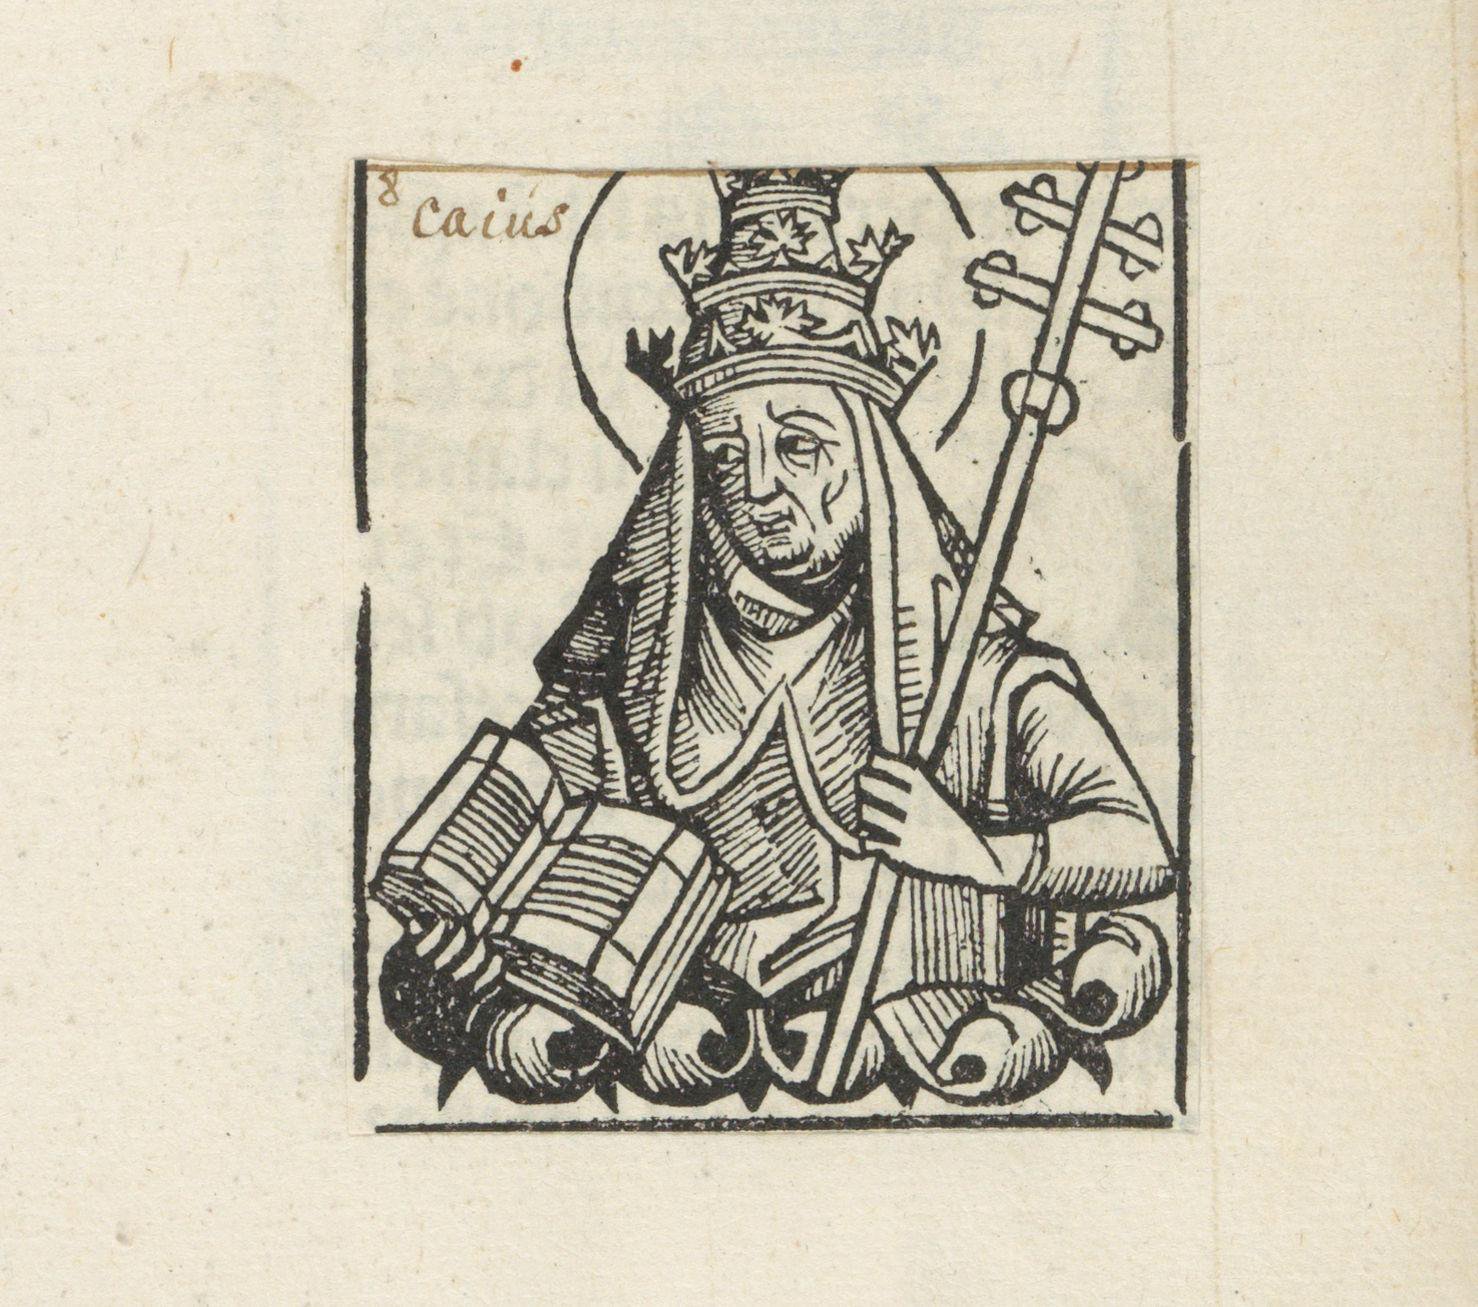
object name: album leaf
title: Paus Cajus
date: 1493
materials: paper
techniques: letterpress printing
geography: nuremberg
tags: pope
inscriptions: inscription: ‘8 Caius’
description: Een bloemkelk met een paus. Hij draagt een tiara en heeft een opengeslagen boek en staf met een dubbel kruis in zijn handen. De nimbus om zijn hoofd vertelt dat deze paus heilig is verklaard. De voorstelling is onderdeel van de opeenvolging pausen in de Liber Chronicarum. De tekst identificeert de man als paus Cajus. De prent maakt deel uit van een album.